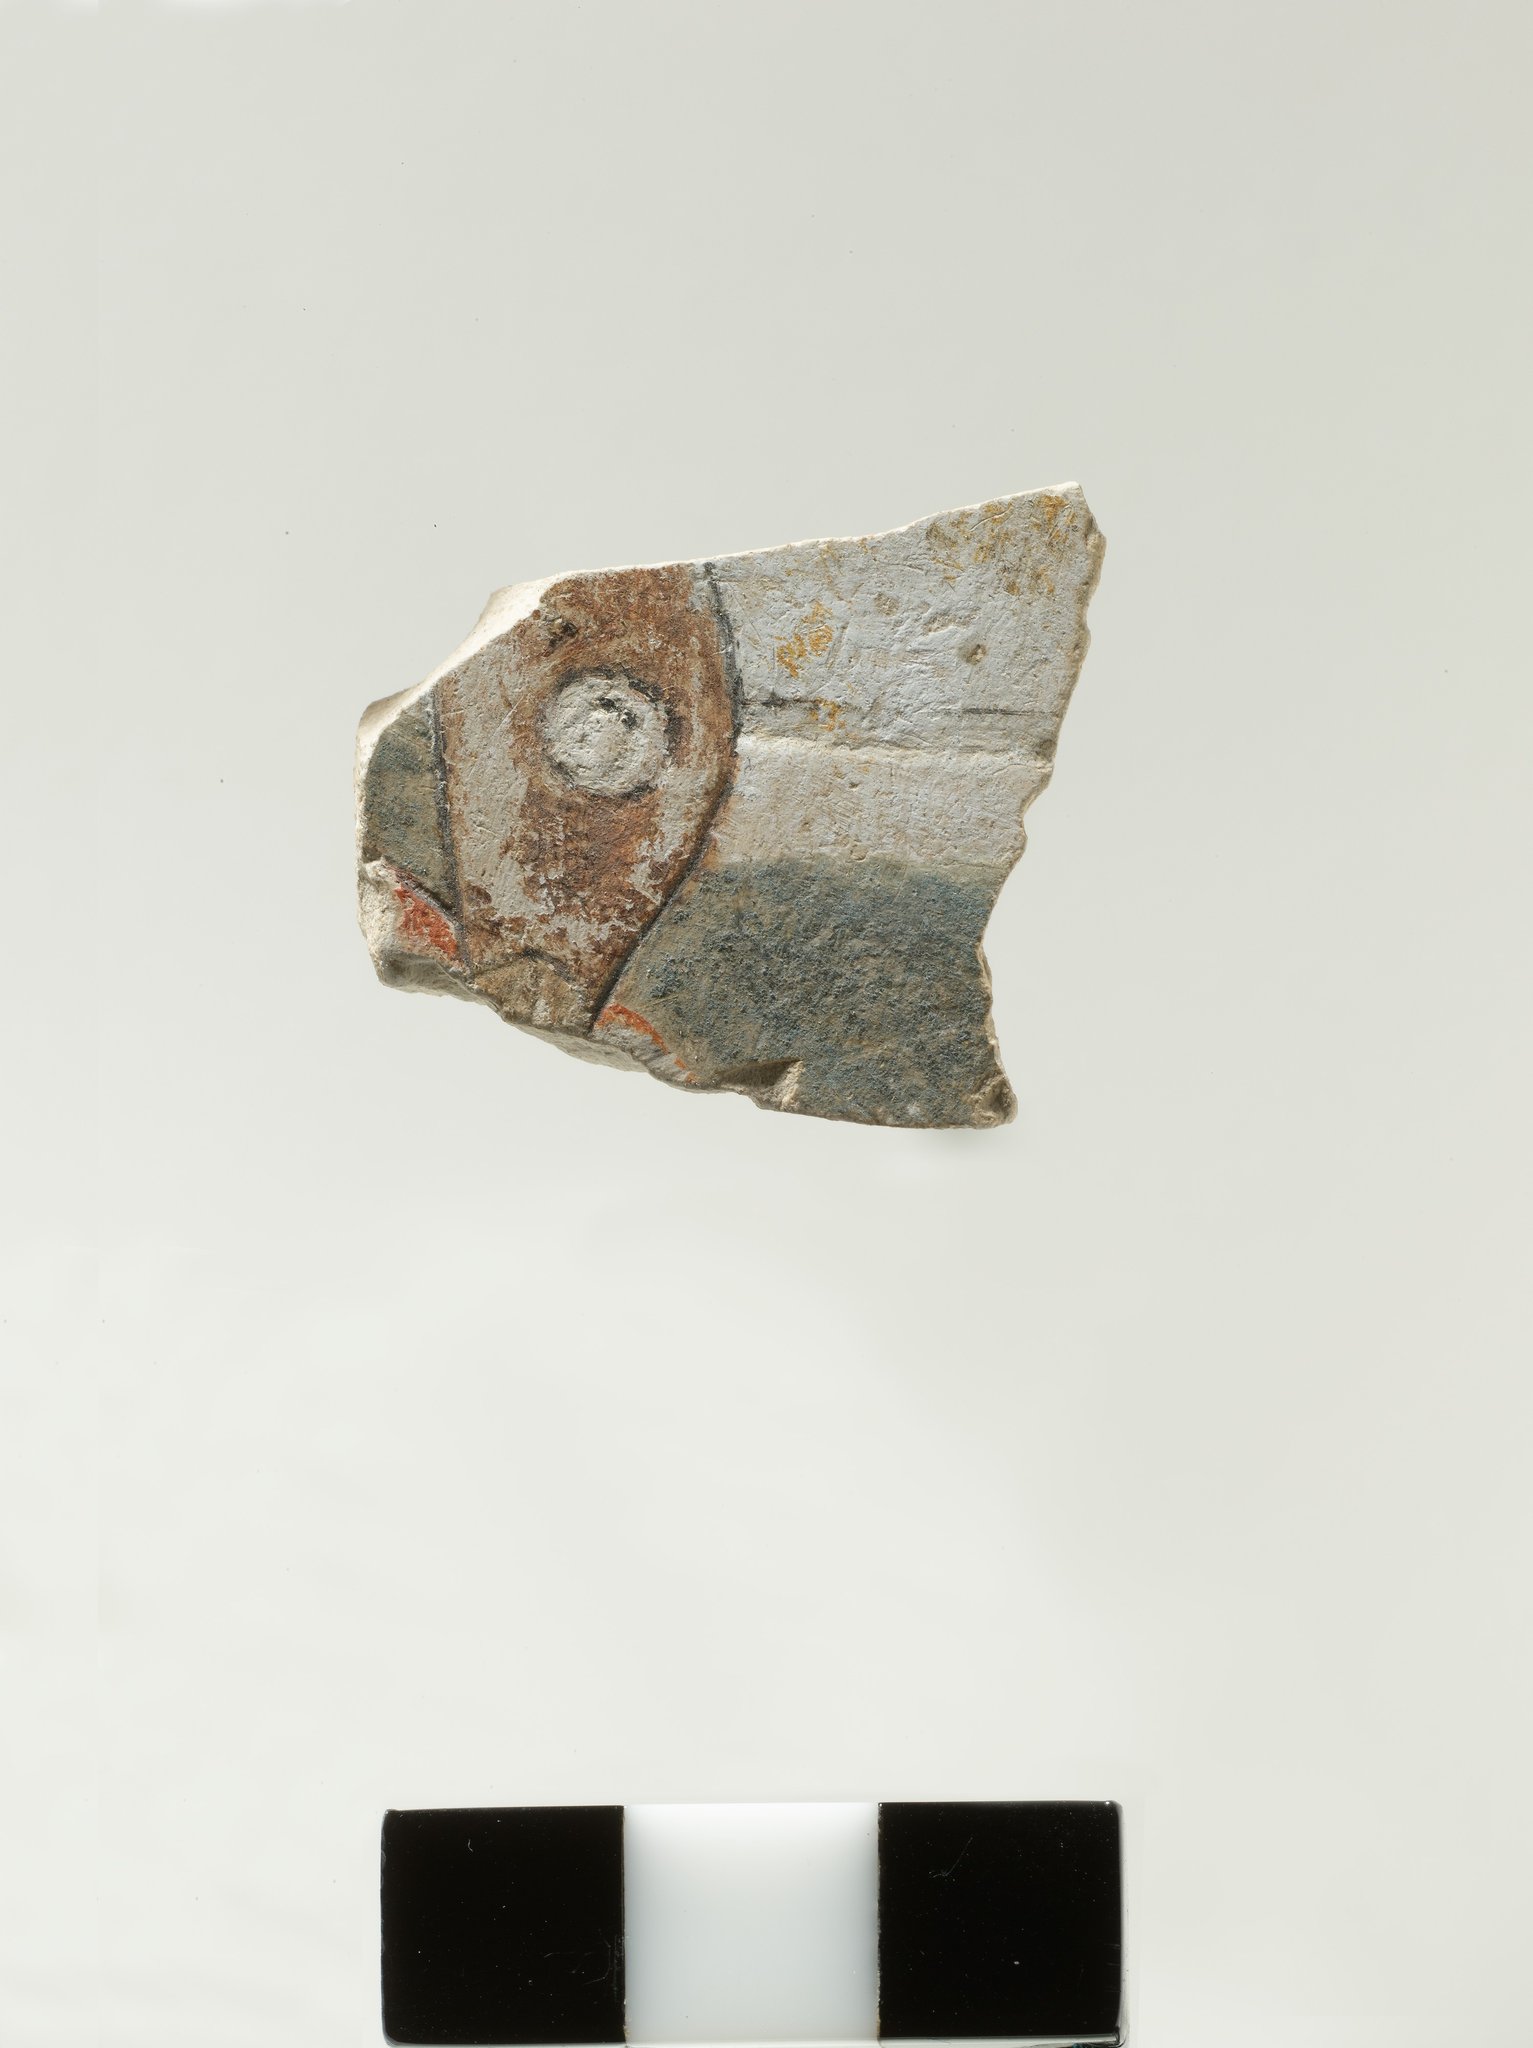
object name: relief fragment, tomb of meketre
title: Relief fragment from the tomb of Meketre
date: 1981-1975 BCE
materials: limestone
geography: egypt